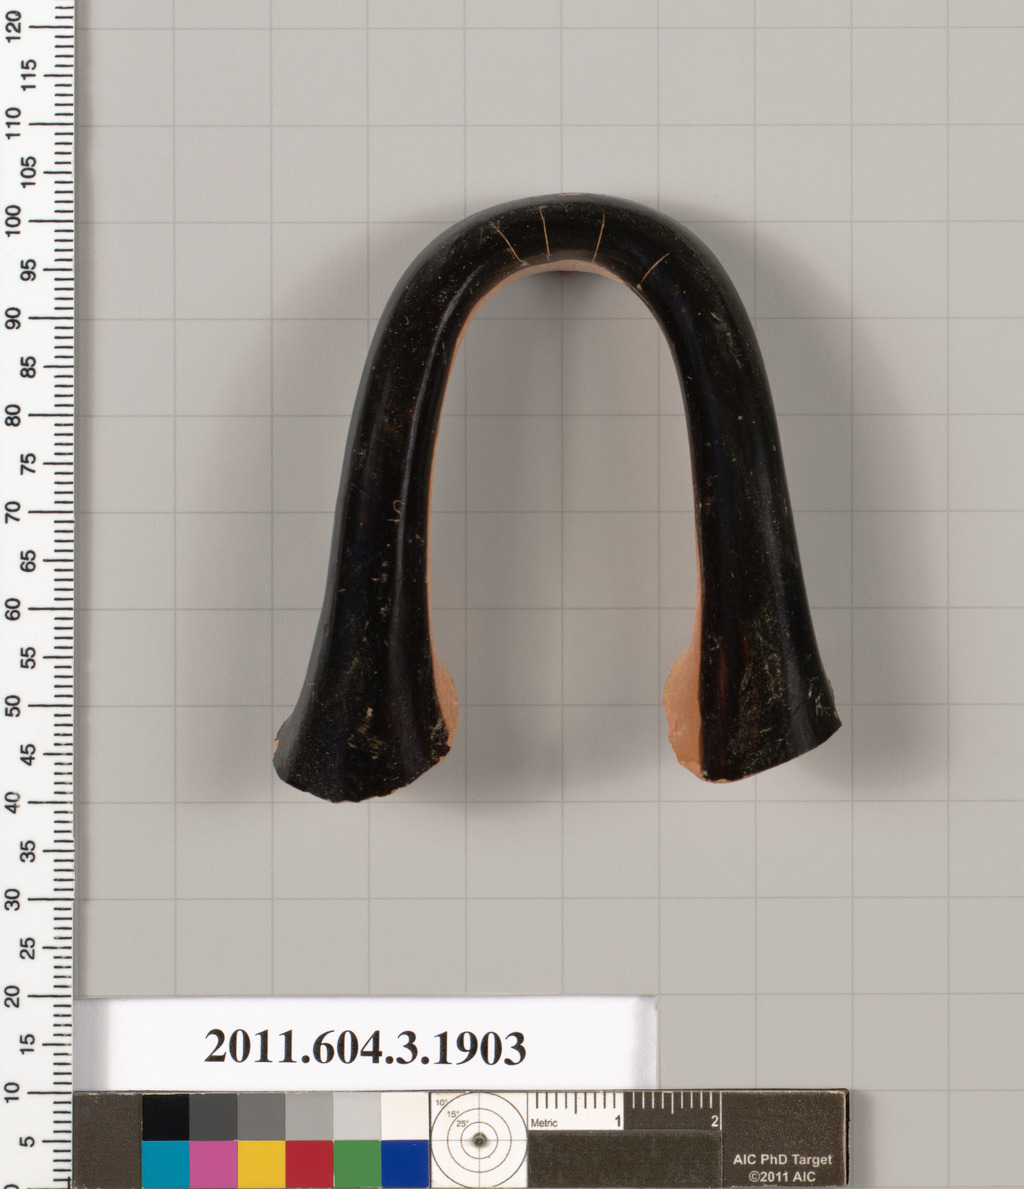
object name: kylix fragment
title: Terracotta fragment of a kylix (drinking cup)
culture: greek, attic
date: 600-401 BCE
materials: terracotta